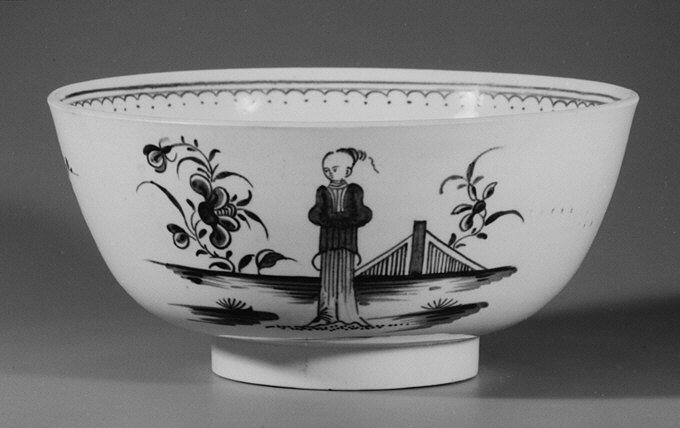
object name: waste bowl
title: Waste bowl (part of a service)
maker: worcester factory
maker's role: factory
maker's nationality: british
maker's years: 1751-2008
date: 1760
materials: soft paste porcelain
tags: men,flowers